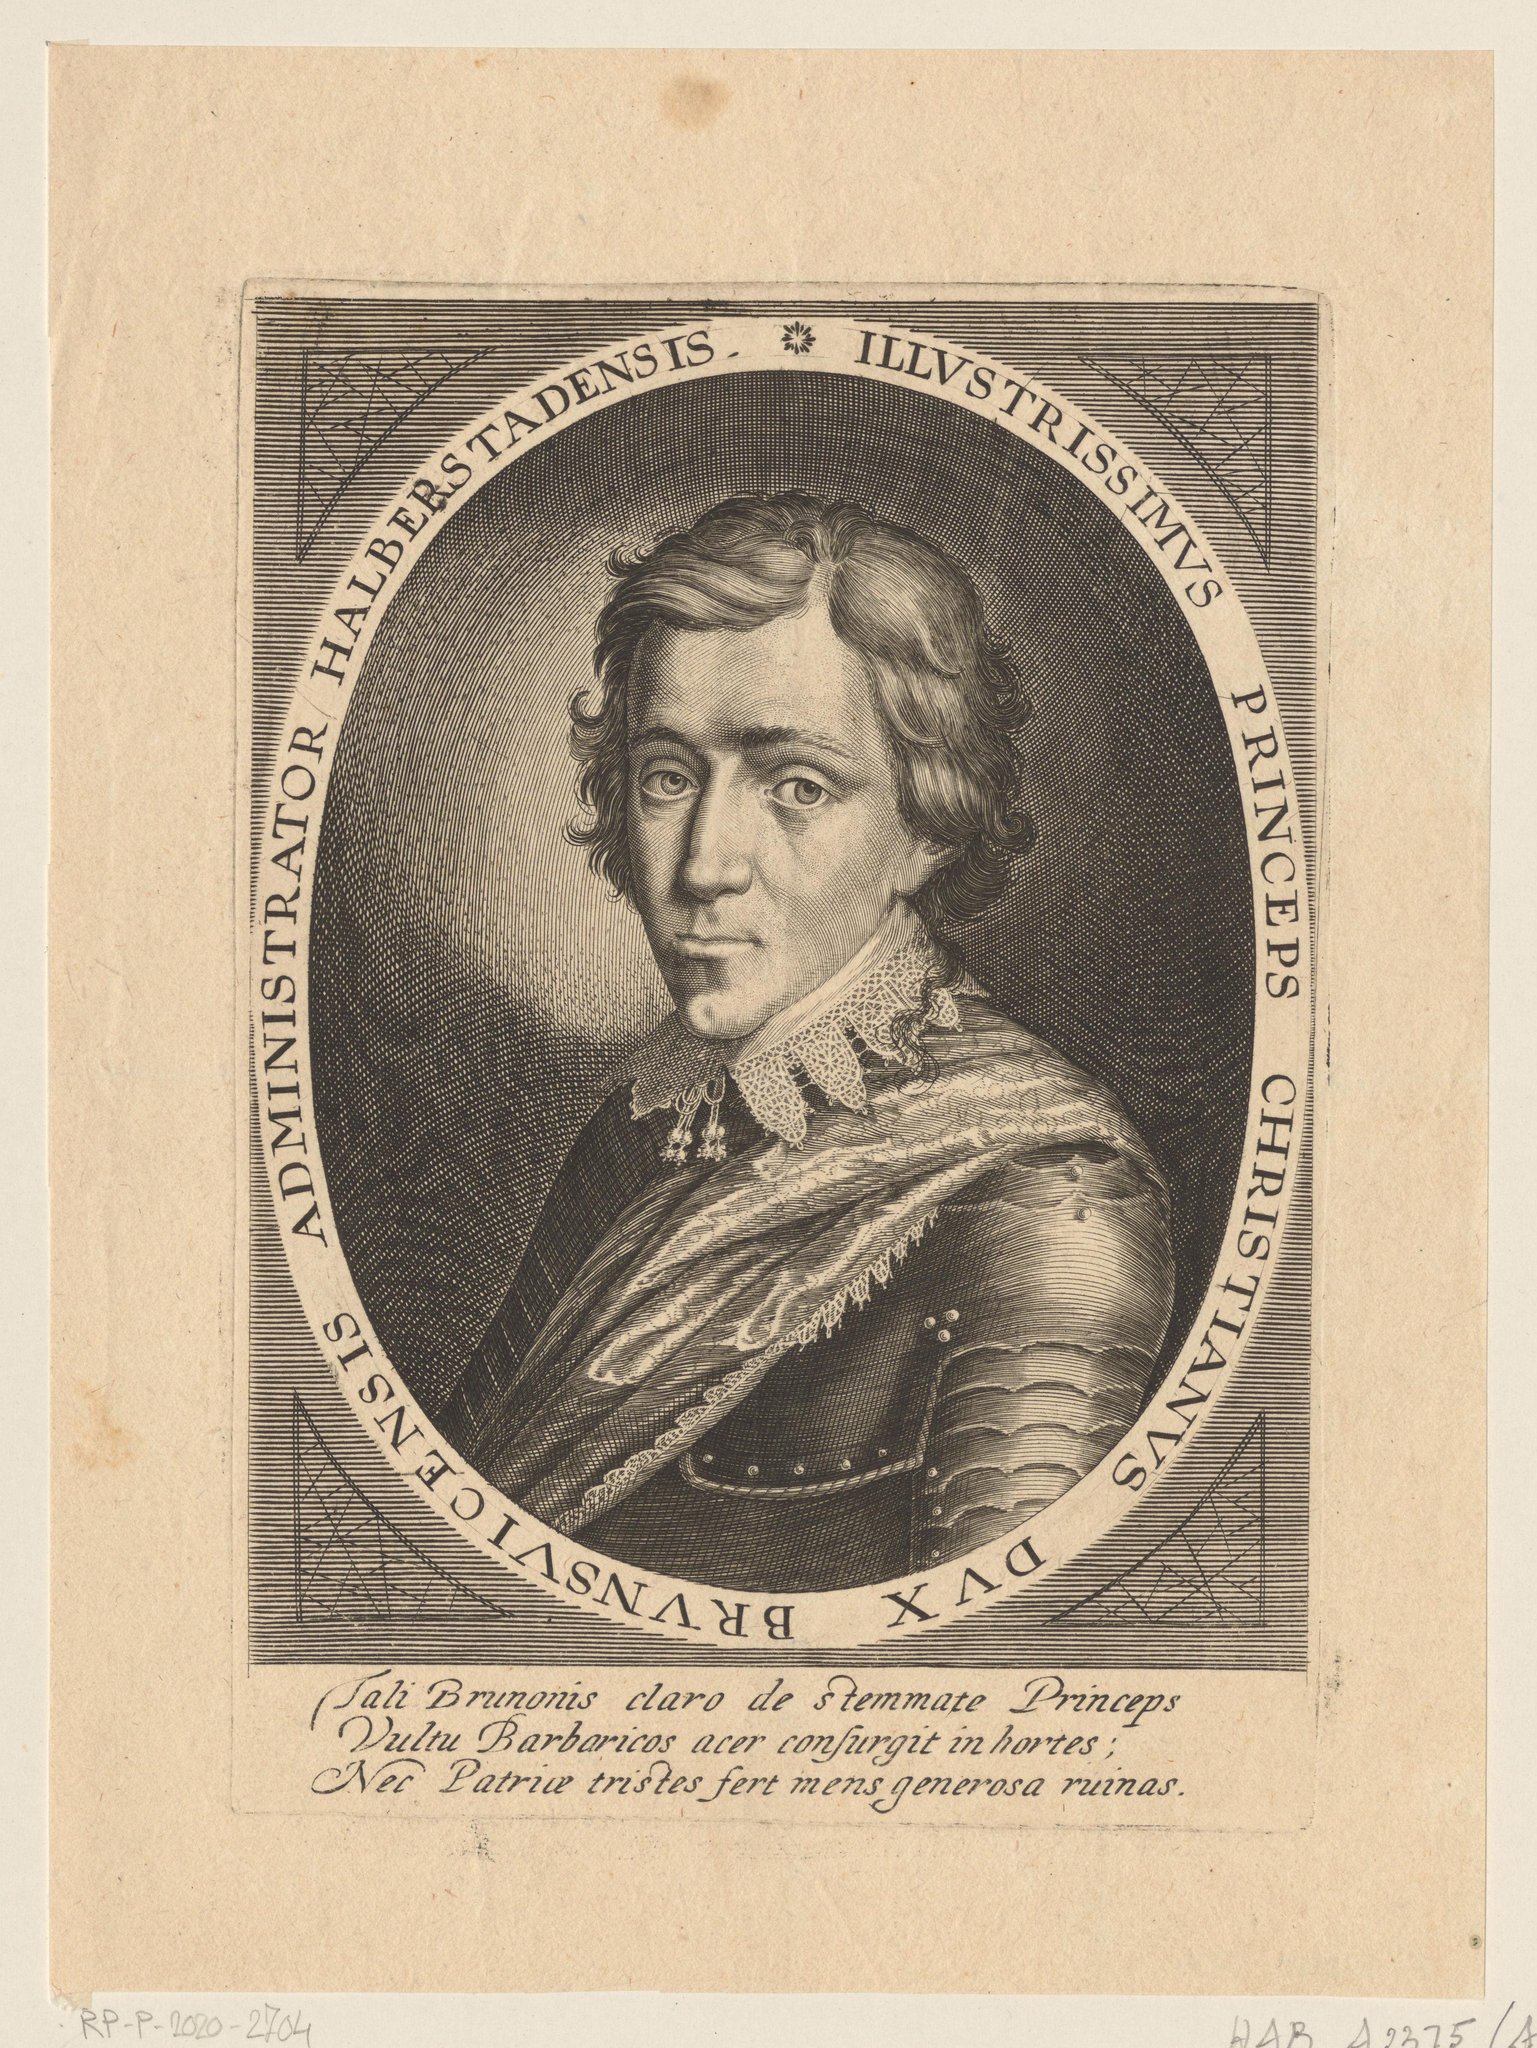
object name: print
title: Portret van Christiaan I, hertog van Brunswijk-Lüneburg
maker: Anonymous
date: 1629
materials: paper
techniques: engraving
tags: historical persons, ruler, sovereign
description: Prent met tekst op verso gebruikt in: Bellus, Nicolaus. Heldenbuch (...). Frankfurt am Main: Kempffer, Erasmus, 1629.